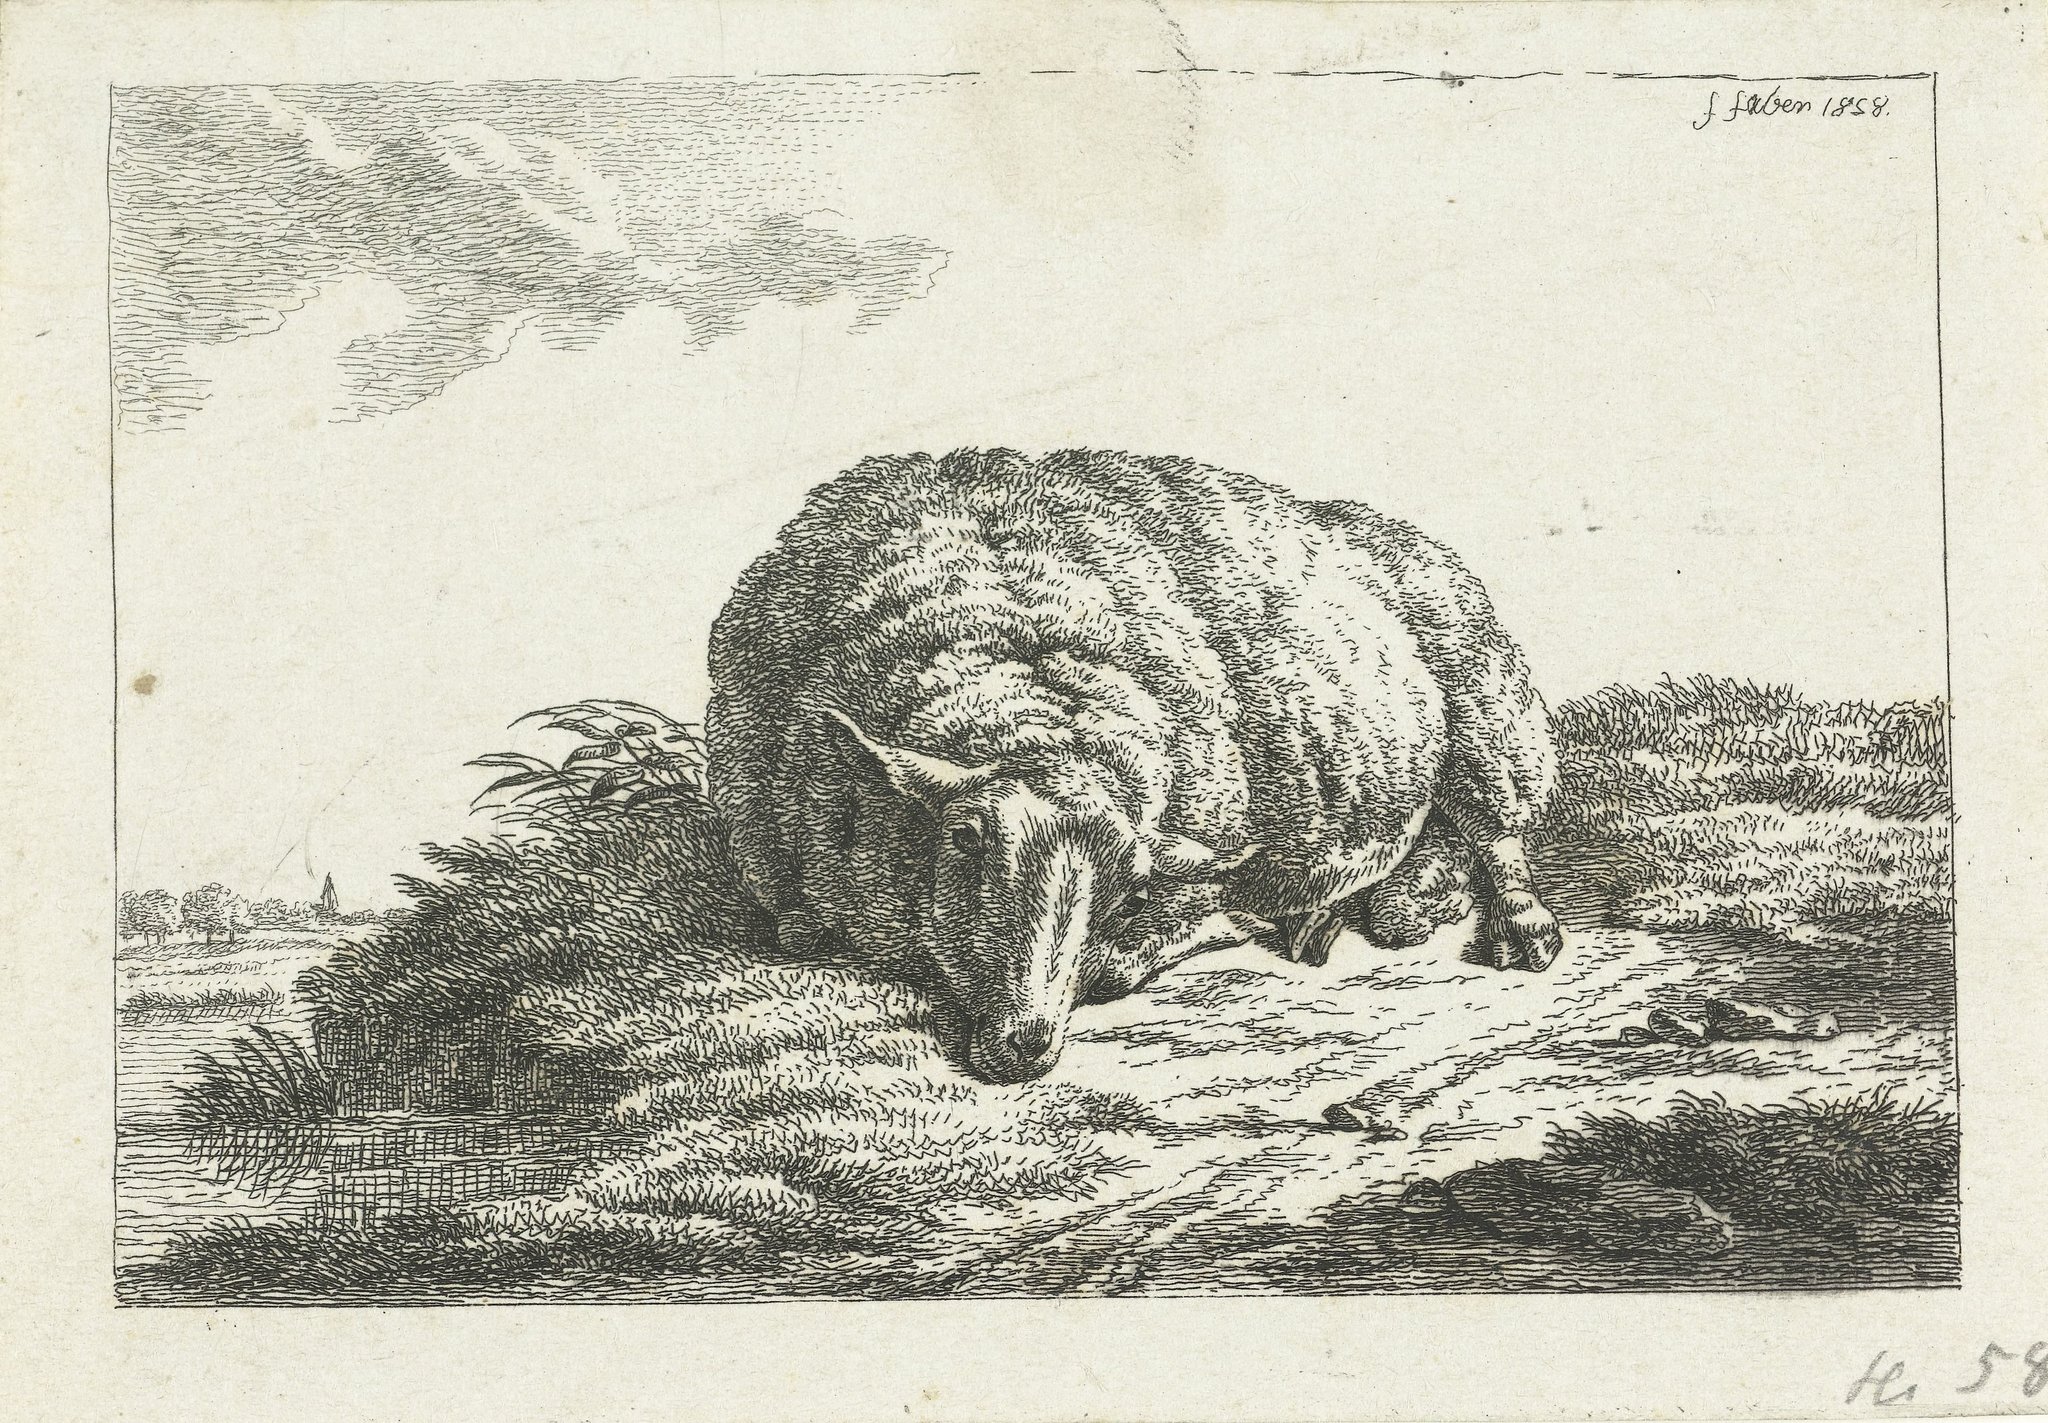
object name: print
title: Liggend schaap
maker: frédéric théodore faber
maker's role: print maker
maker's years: 1782-1844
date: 1828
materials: paper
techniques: etching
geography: brussels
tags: sheep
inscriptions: collector's mark: Lugt 1485, collector's mark: Lugt 2228